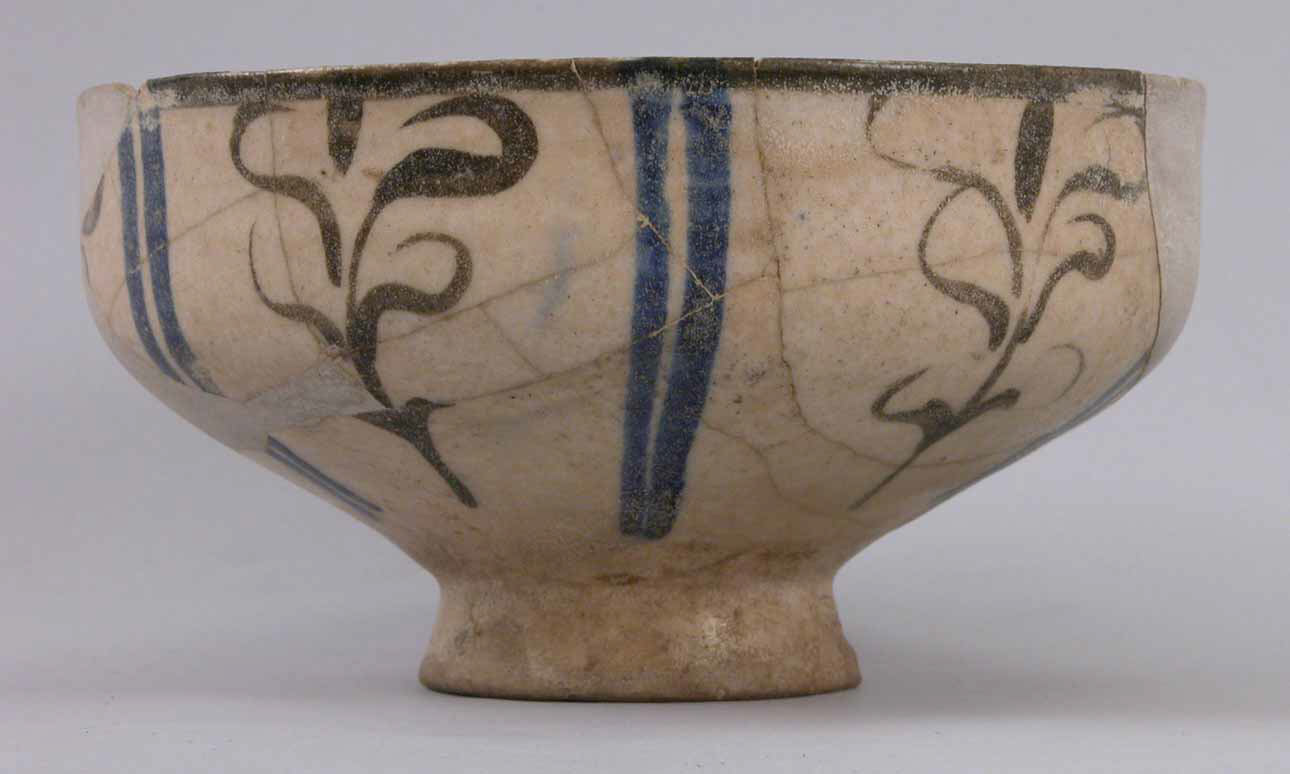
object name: fragmentary bowl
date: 1201-1300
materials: stonepaste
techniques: painting, underglaze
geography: iran